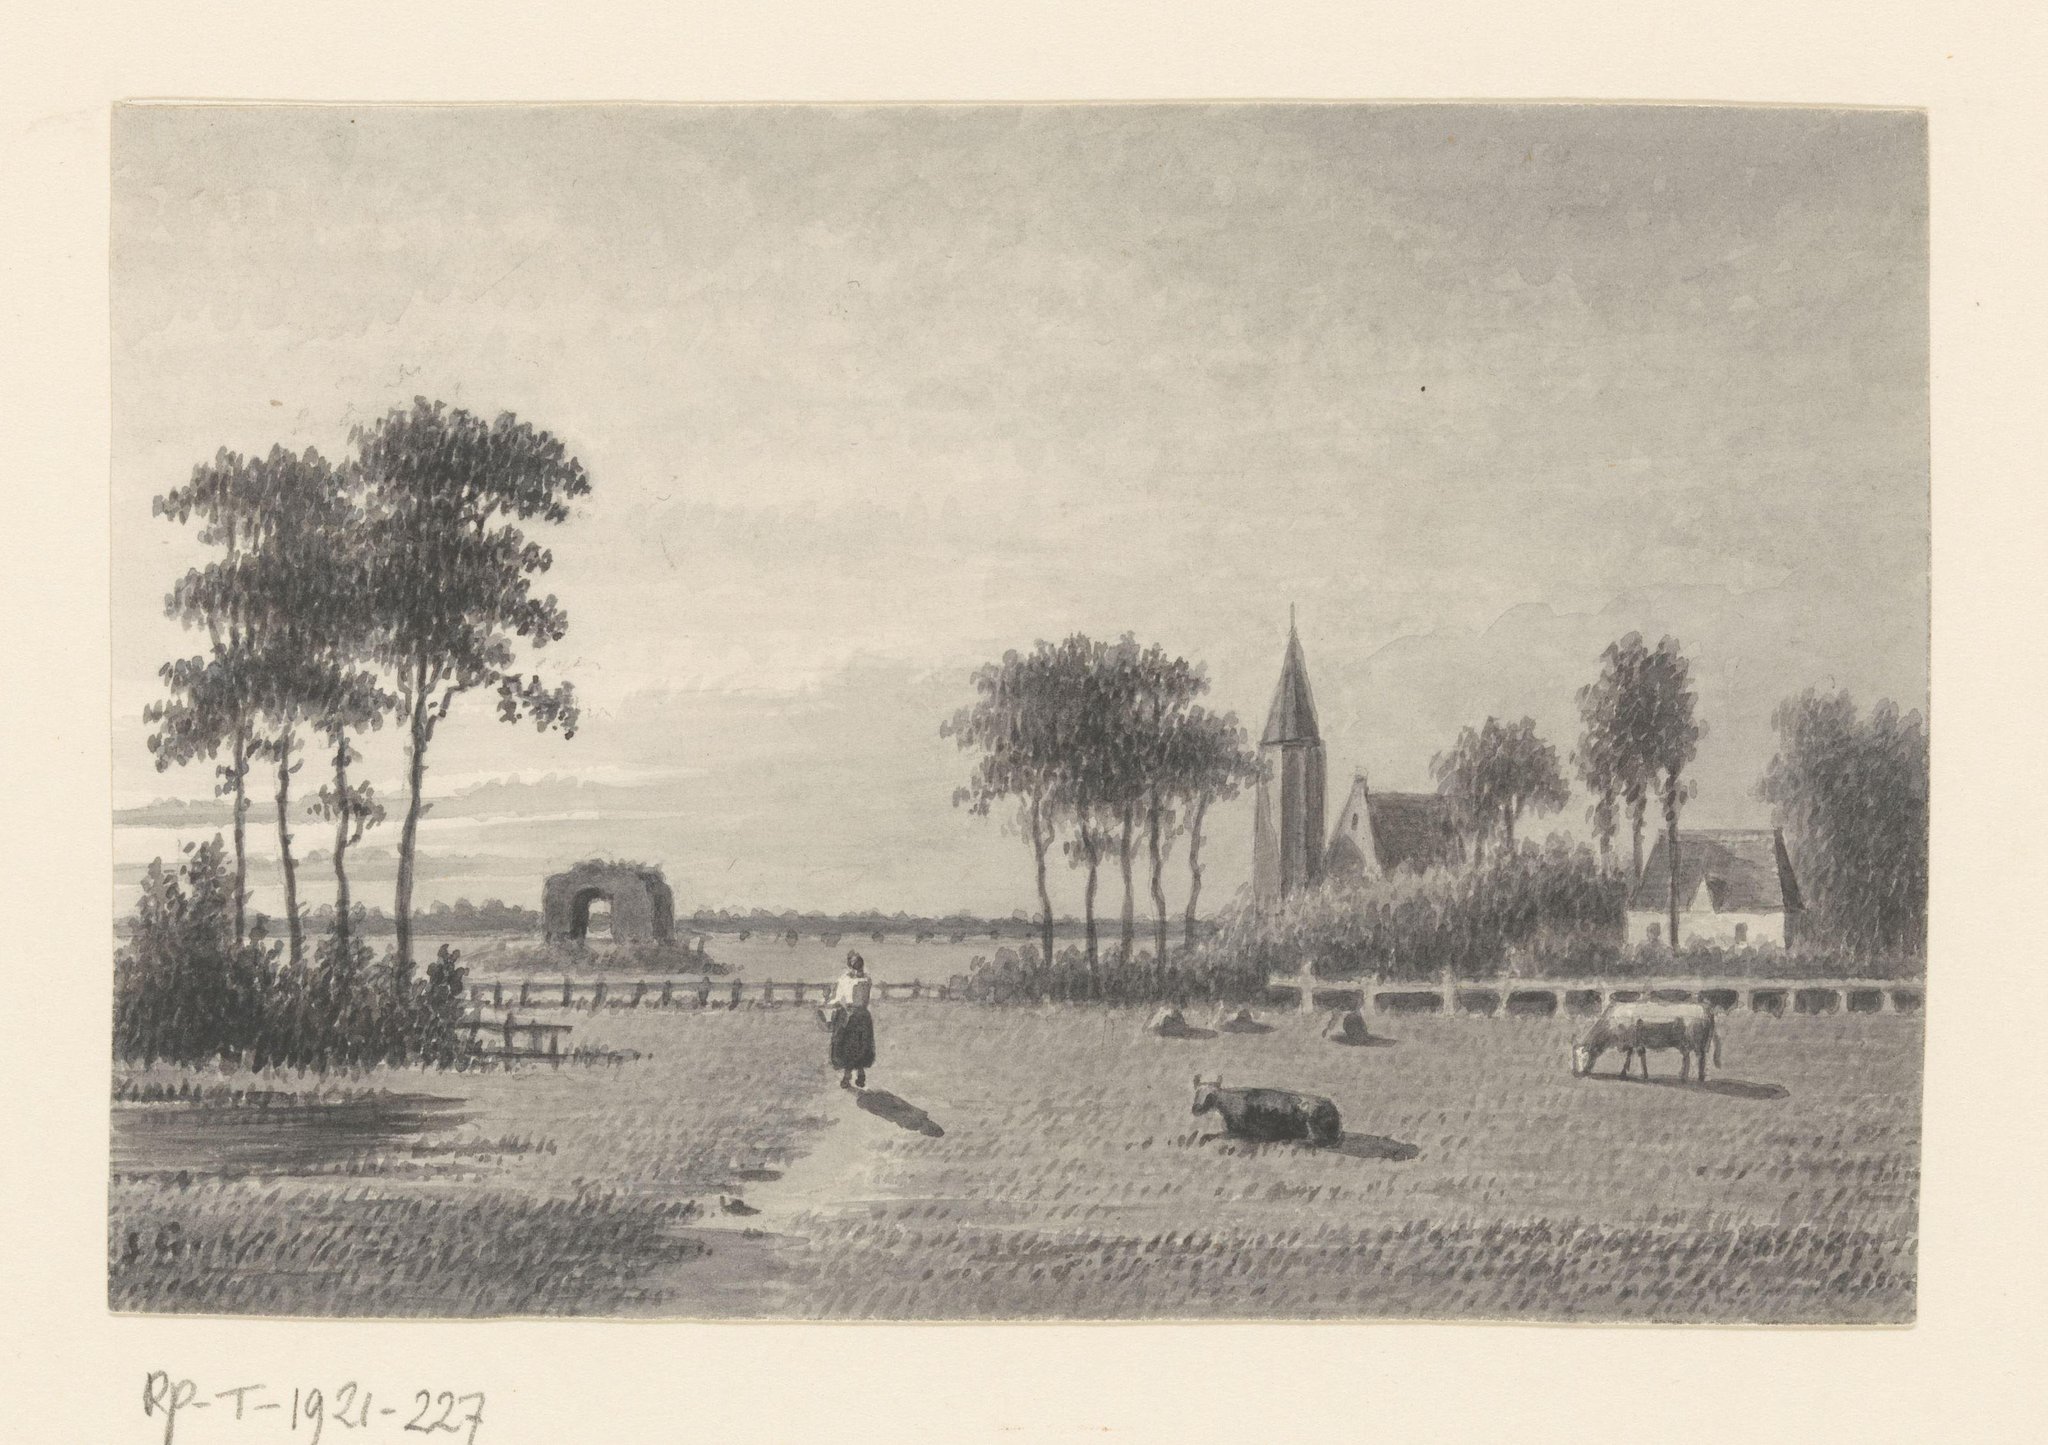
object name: drawing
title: Landschap met een gezicht op de ruïnes van Huis ter Kleef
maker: Anonymous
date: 1750-1800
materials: ink, paper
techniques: brush, pen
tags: landscape with ruins (+ city(-scape) with figures, staffage), ruin of a dwelling, house, castle, etc.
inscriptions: monogram: ‘J.G. [?]’, collector's mark: Lugt 2233